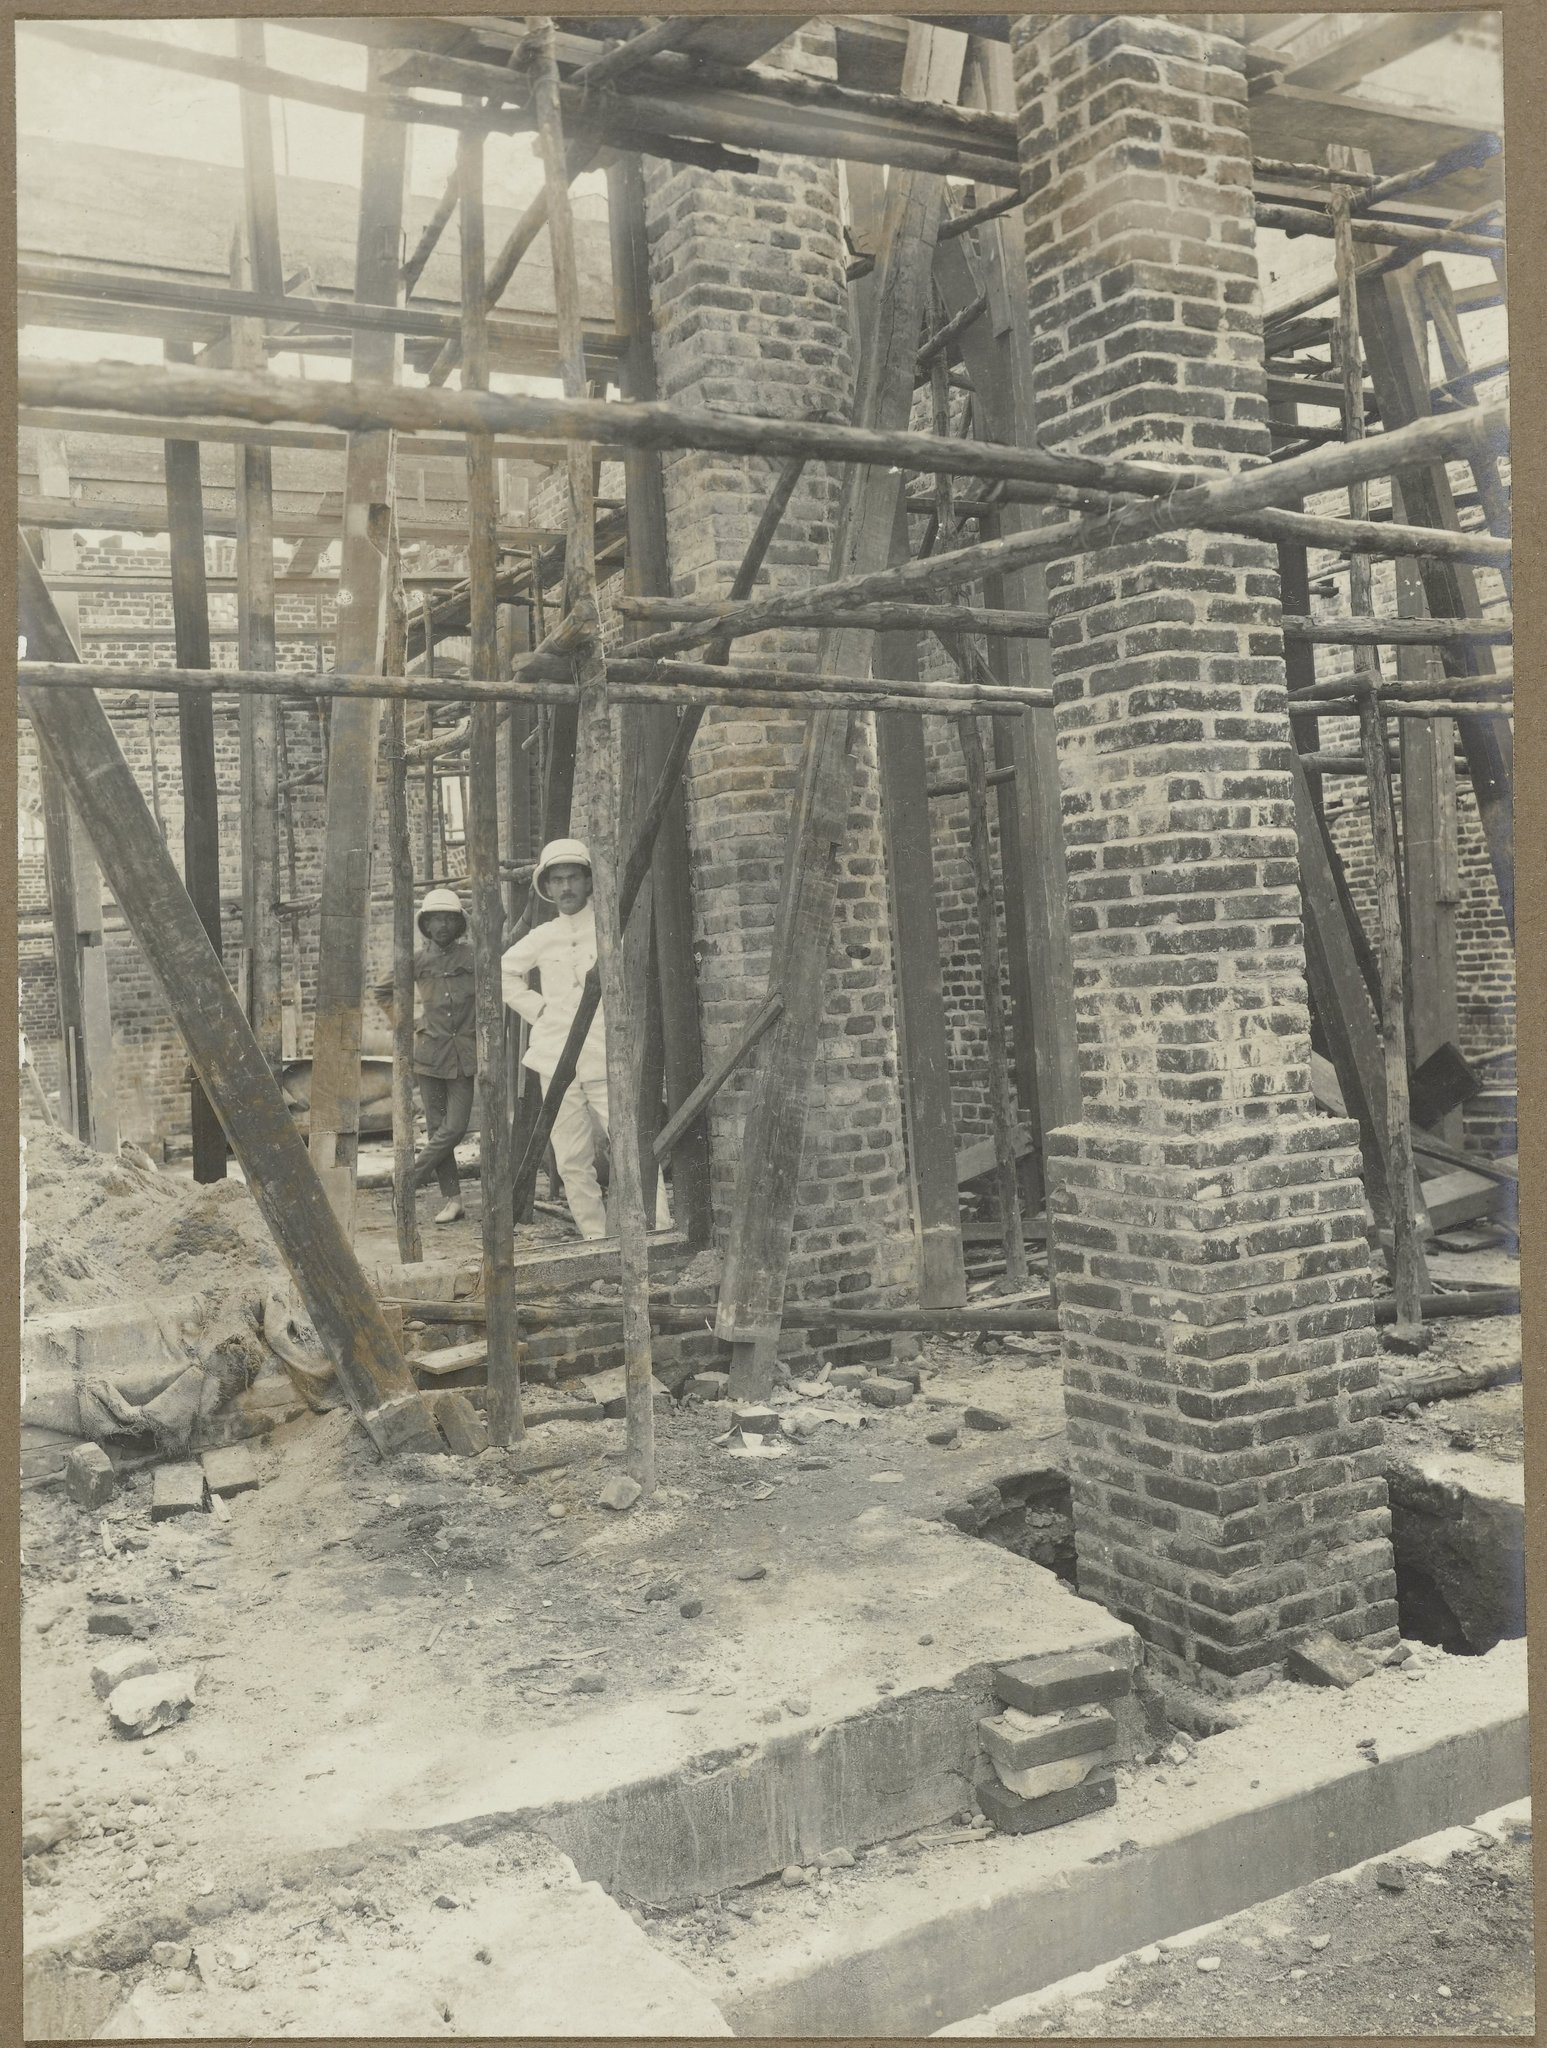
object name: photograph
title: Bennink op de bouwplaats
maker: Anonymous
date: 1914-1919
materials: photographic support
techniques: gelatin silver print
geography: medan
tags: architect at work, making the overground structures (~ building activities), representation of real building (either existing or having existed)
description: Bennink op de bouwplaats van een pand in een blok aan een straat, waarschijnlijk te Medan. Foto in het fotoalbum van het Nederlandse architectenbureau en aannemersbedrijf Bennink en Riphagen te Medan in de jaren ca. 1914-1919.